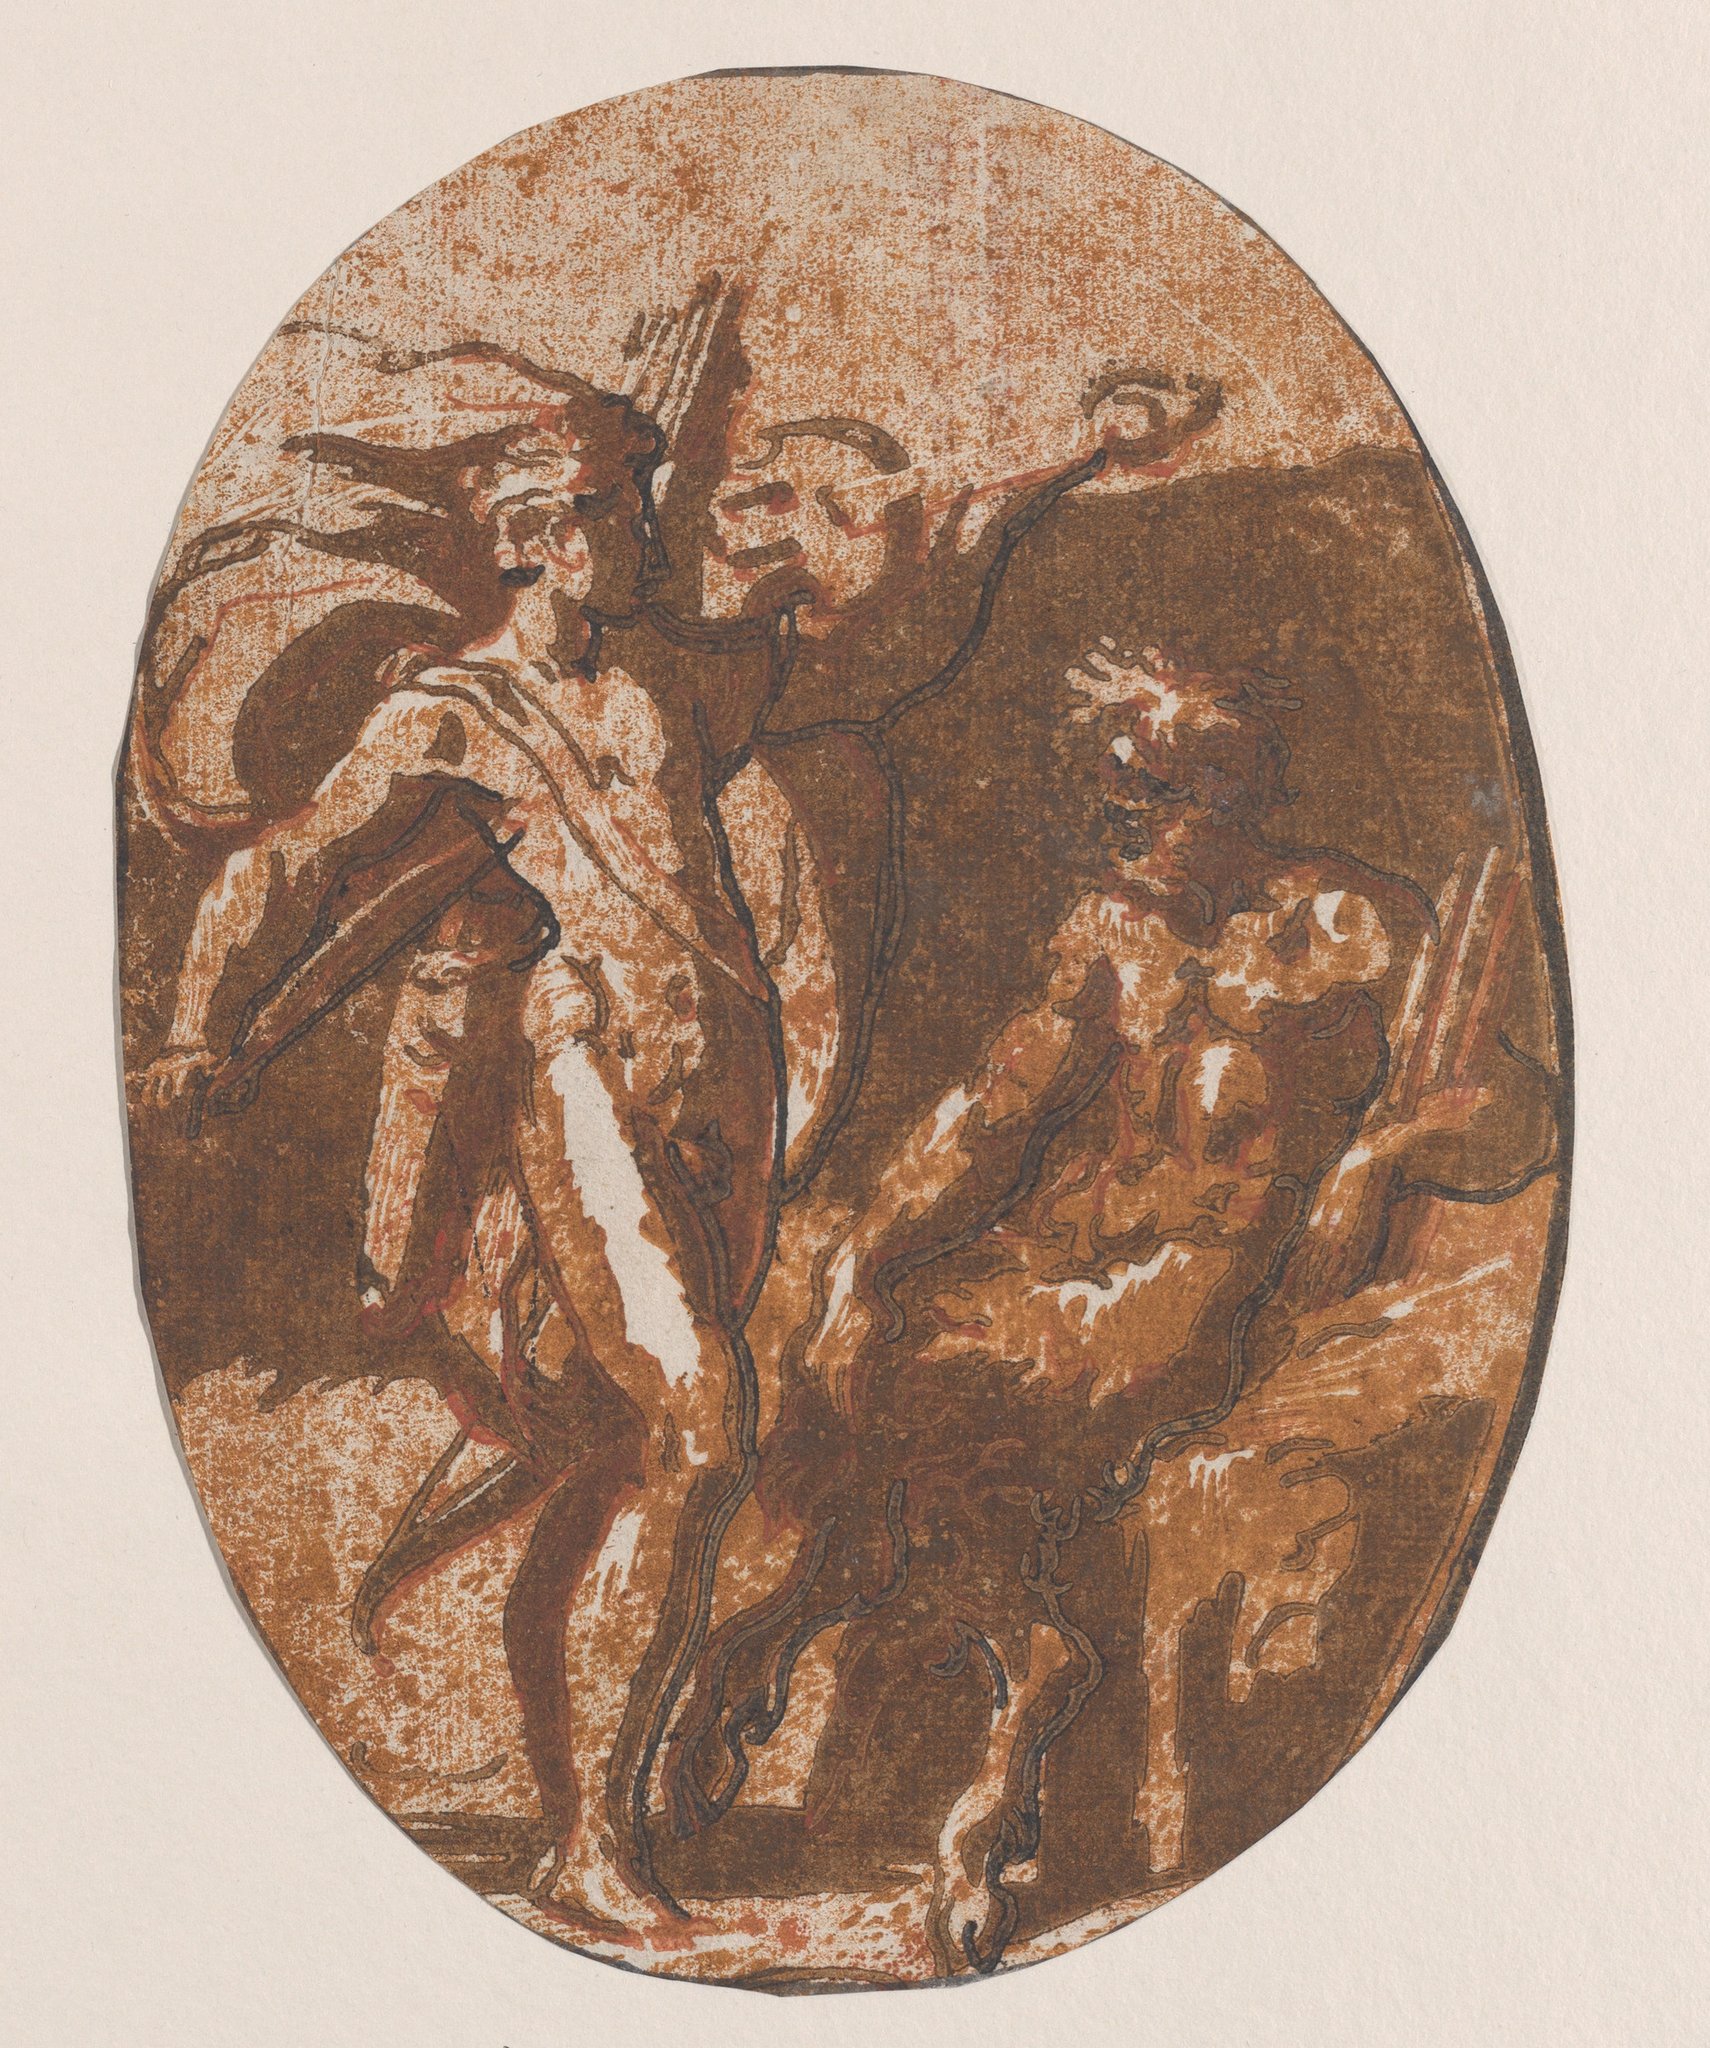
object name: print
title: The contest between Apollo and Marysas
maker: niccolò vicentino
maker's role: artist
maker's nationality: italian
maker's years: 1510-1550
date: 1540-1550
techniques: woodcut, printing